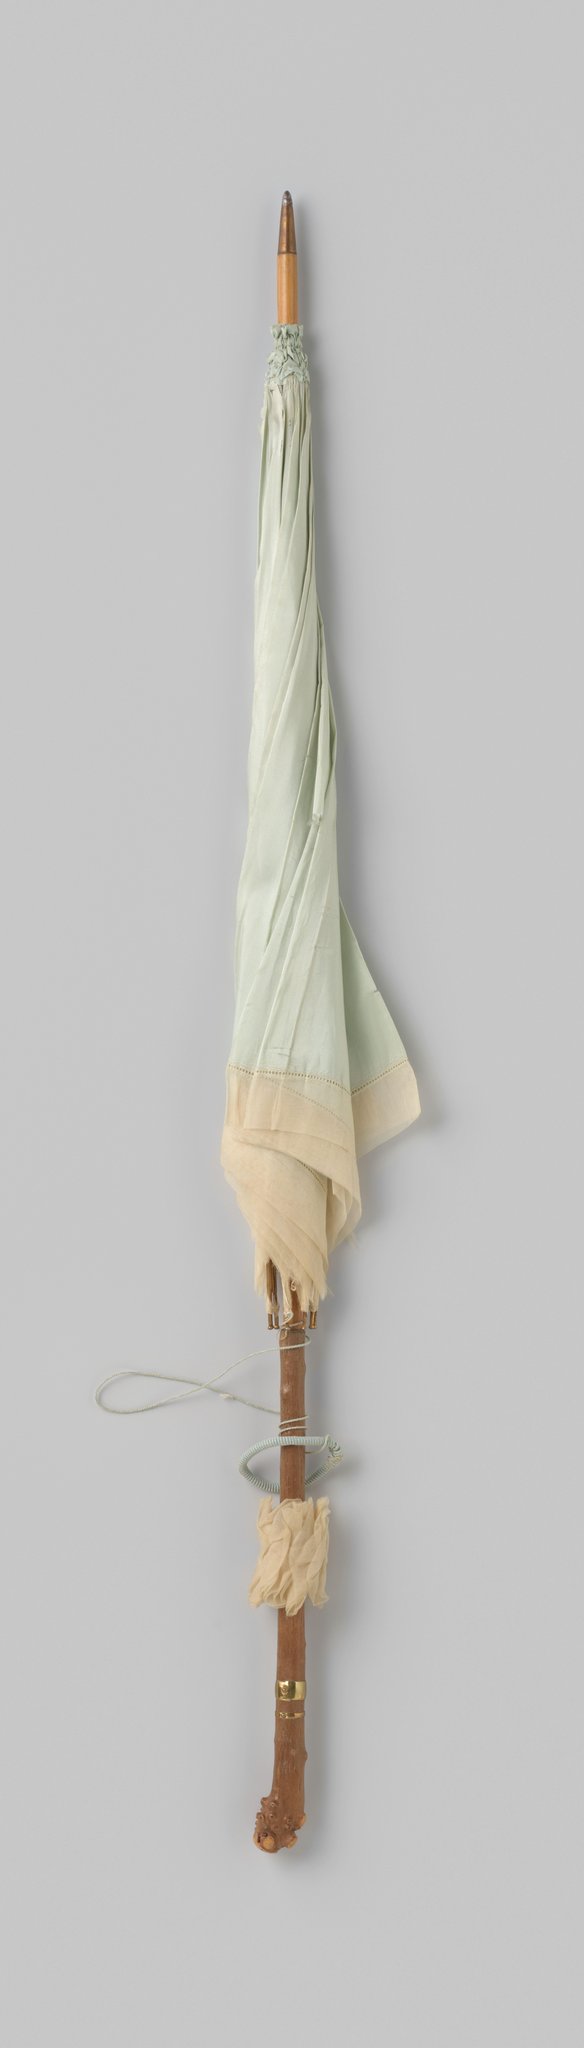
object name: parasol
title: Parasol met dek van lichtblauwe zijde waaraan een rand van ecrukleurige zijde, op een stok van bamboe, waaraan een handvat van een houten knoest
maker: Anonymous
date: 1910-1915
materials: bamboo, copper, cotton, silk, wood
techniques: casting, cutting, weave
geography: paris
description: Parasol met knoestige houten knop met vergulde banden en lichtblauwe zijden bespanning met á-jour aanhezette witgazen zoom. Lichtkleurig houten stok met bovenaan een greep van een tak met verspreide knoest, die in een ombuigende knop vol knoesten eindigt. Versierd met wit gazen ruche bij de knop. Baleinen van messing, verlopend in de knopjes. Wordt met blauwe sluitring bijeengehouden.